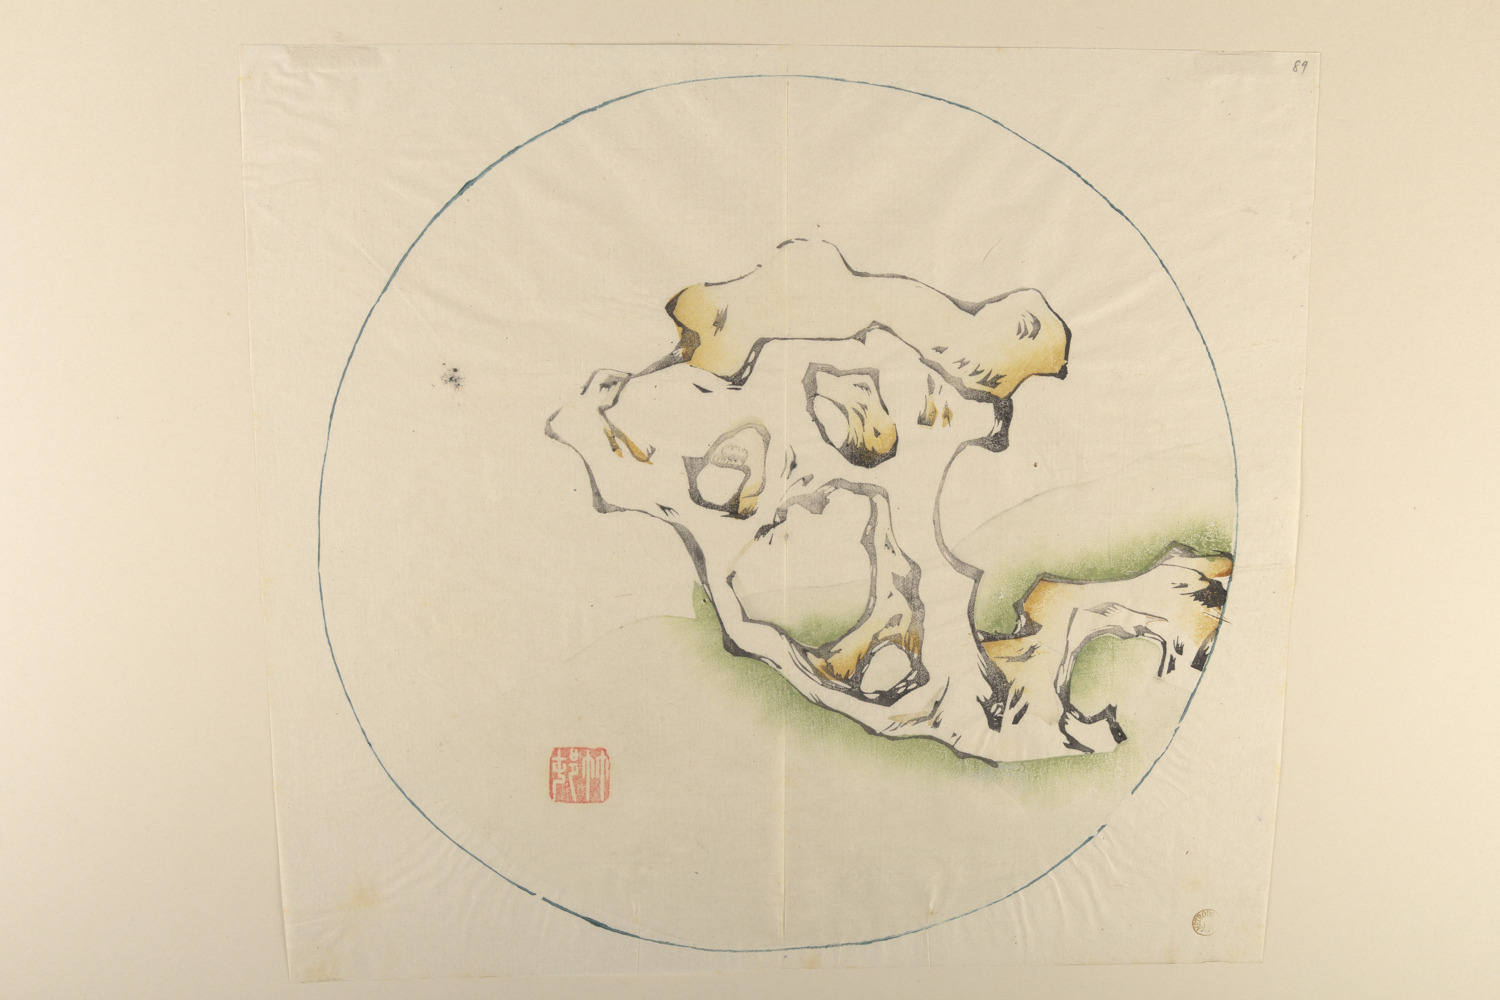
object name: print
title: Page from Shi Zhu Zhai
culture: chinese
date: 1736-1795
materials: ink, paper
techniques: polychrome, woodblock print